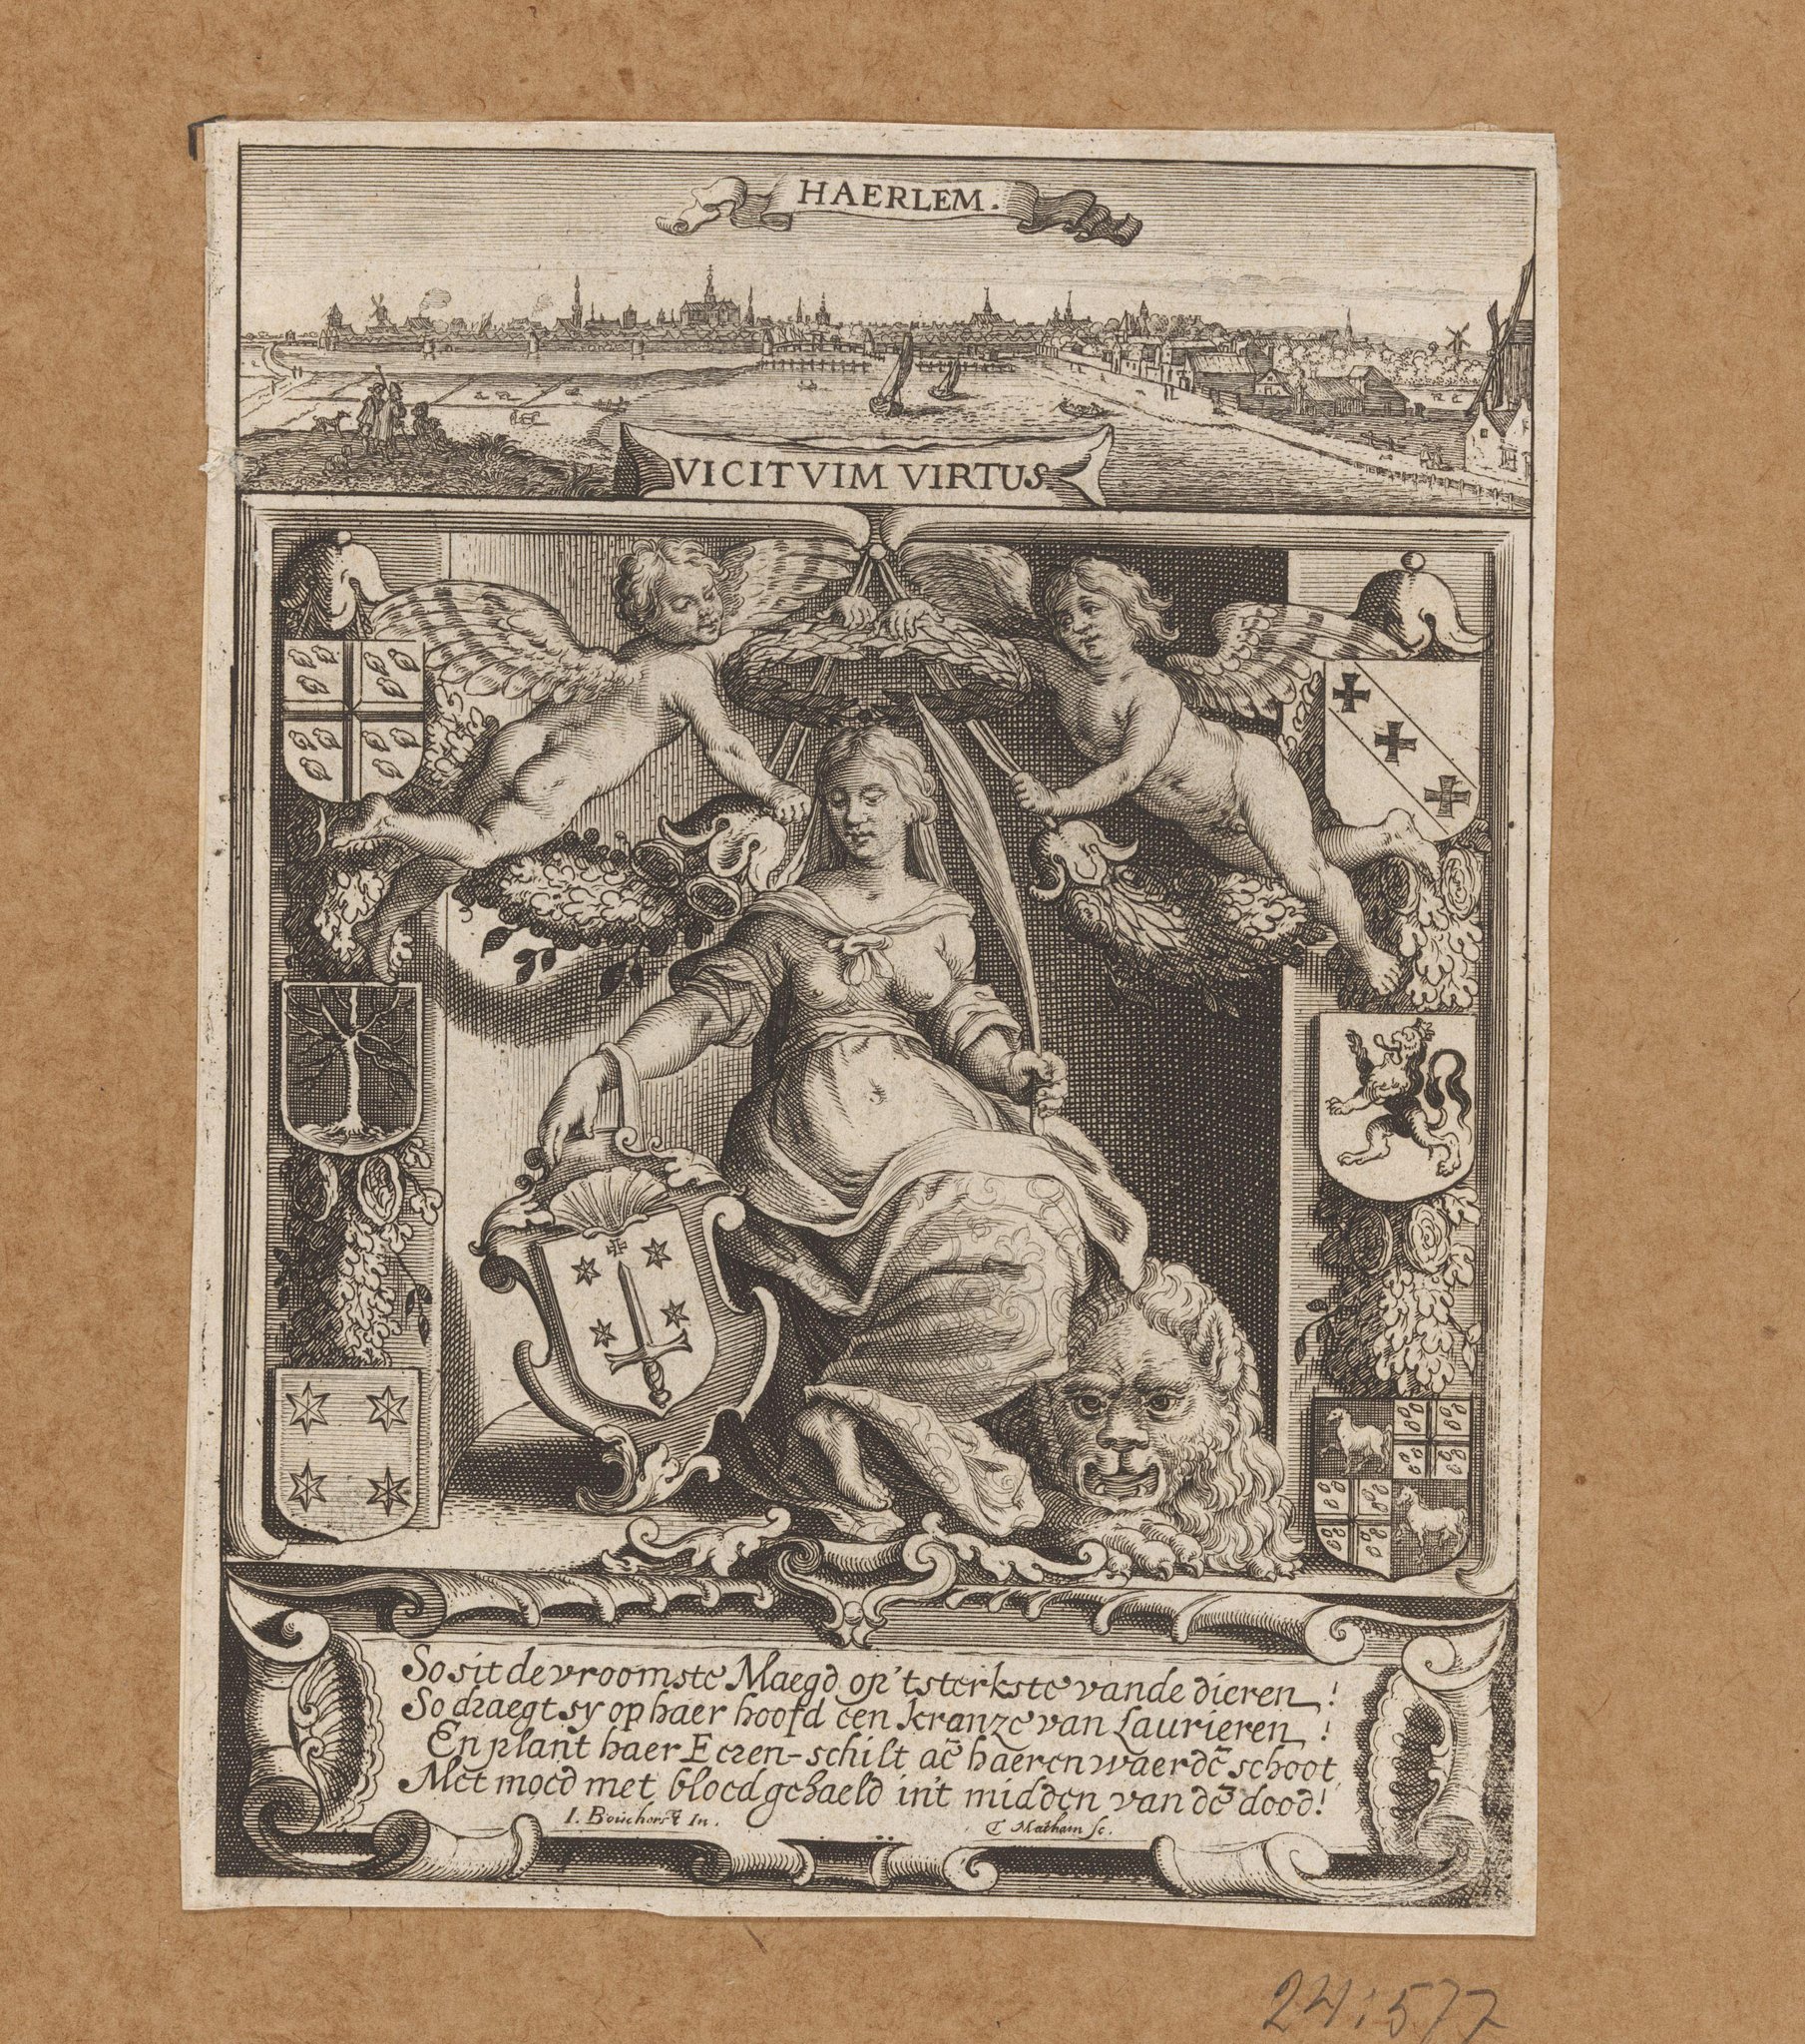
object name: print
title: Haerlem. Vicituim virtus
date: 1621-1676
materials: paper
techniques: etching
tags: city-view in general; 'veduta', sitting figures of mary (alone), haarlem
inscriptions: collector's mark: Lugt 2233